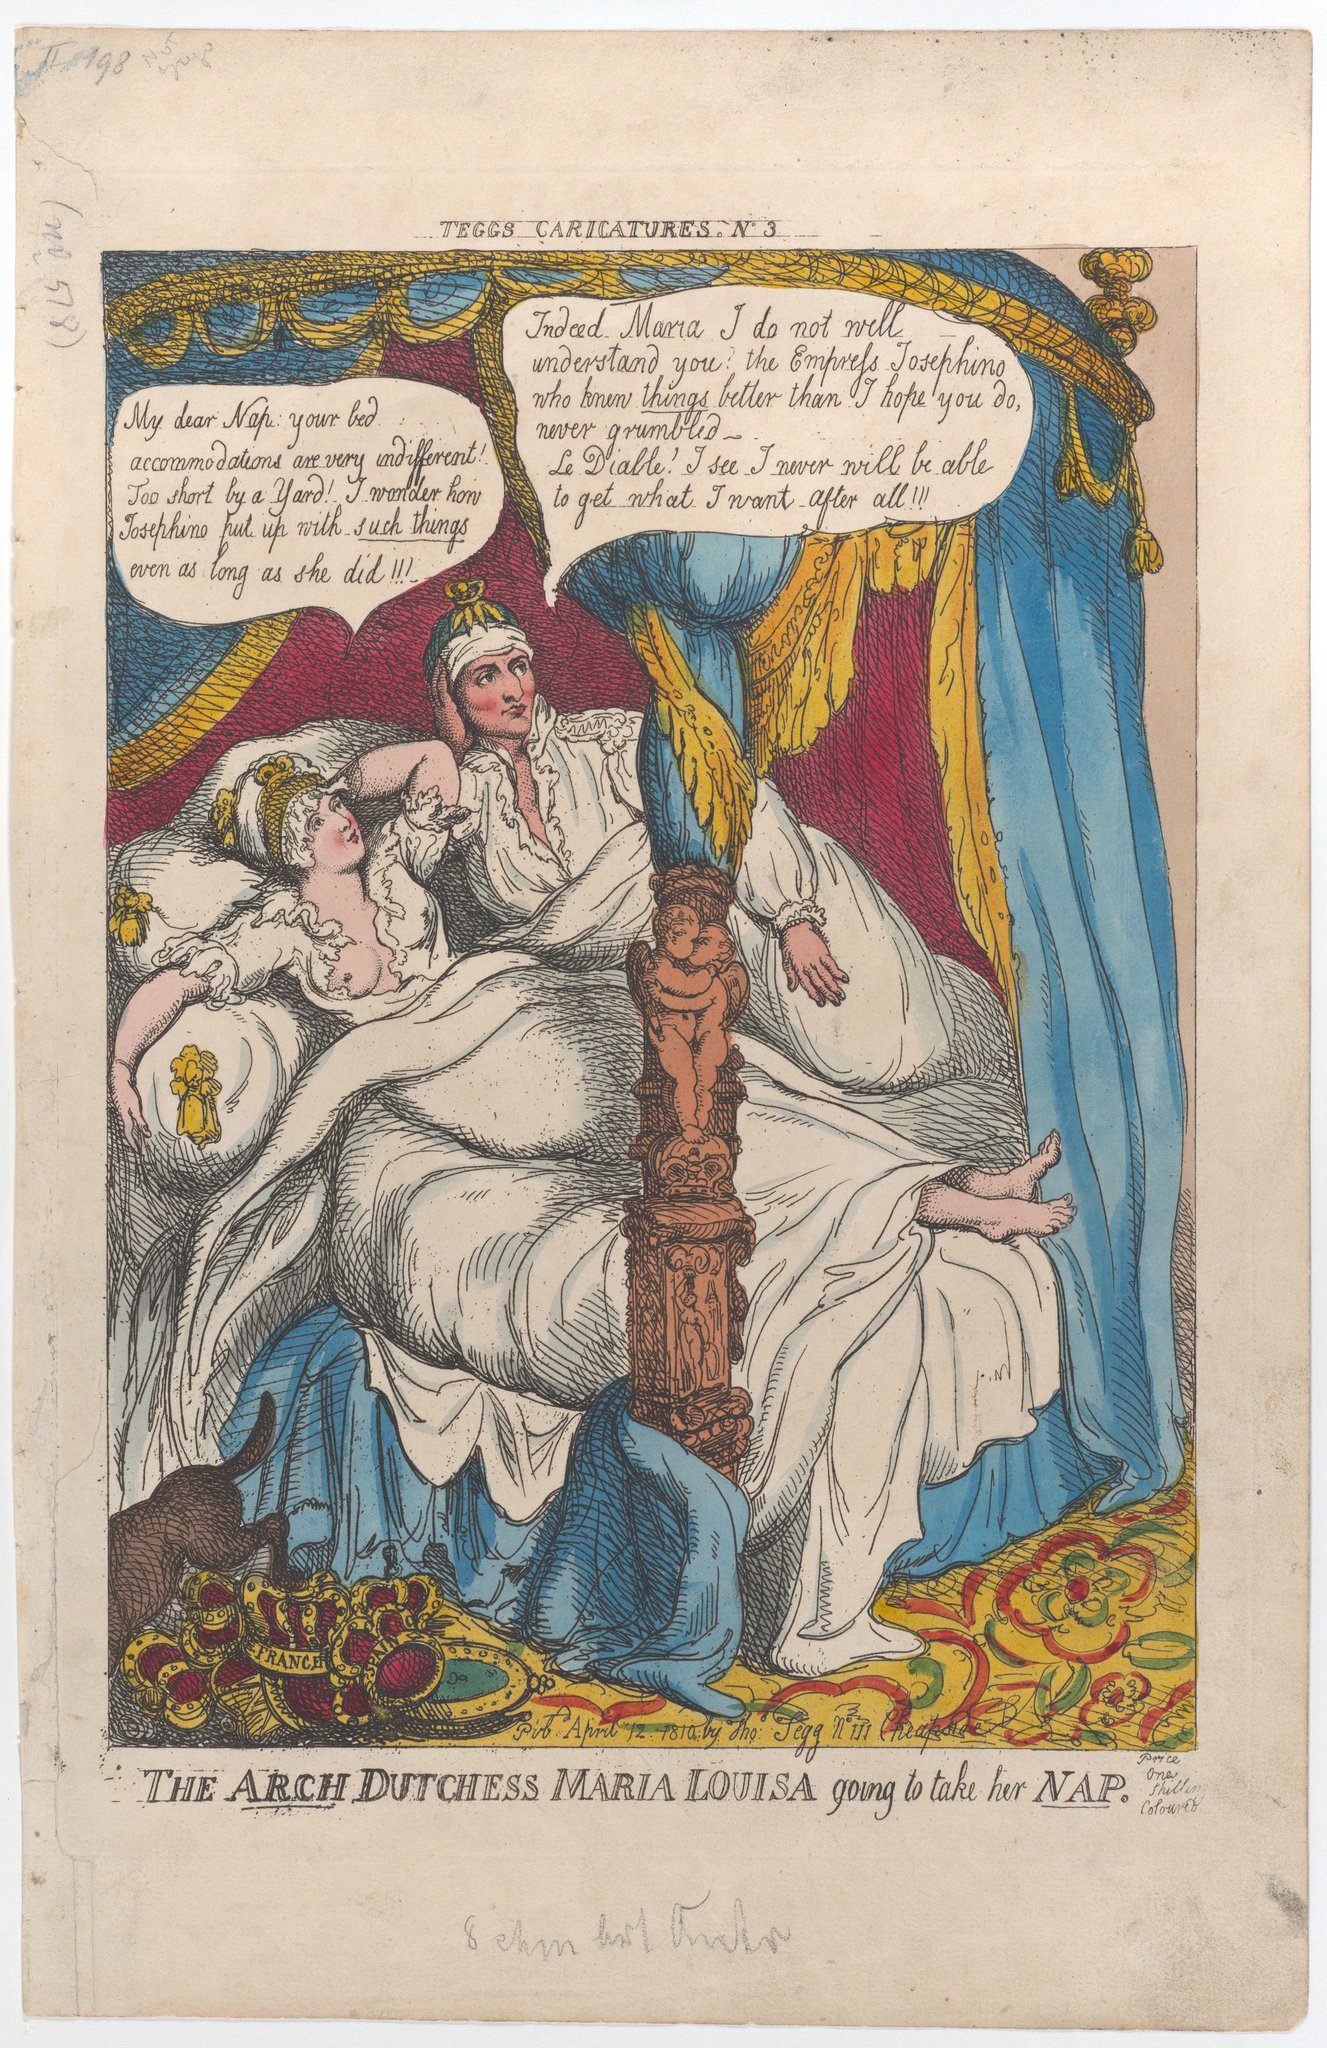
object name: print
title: The Arch Duchess Maria Louisa Going to Take Her Nap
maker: thomas rowlandson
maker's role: artist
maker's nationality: british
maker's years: 1757-1827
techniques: etching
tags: satire,napoleon i,men,women,beds